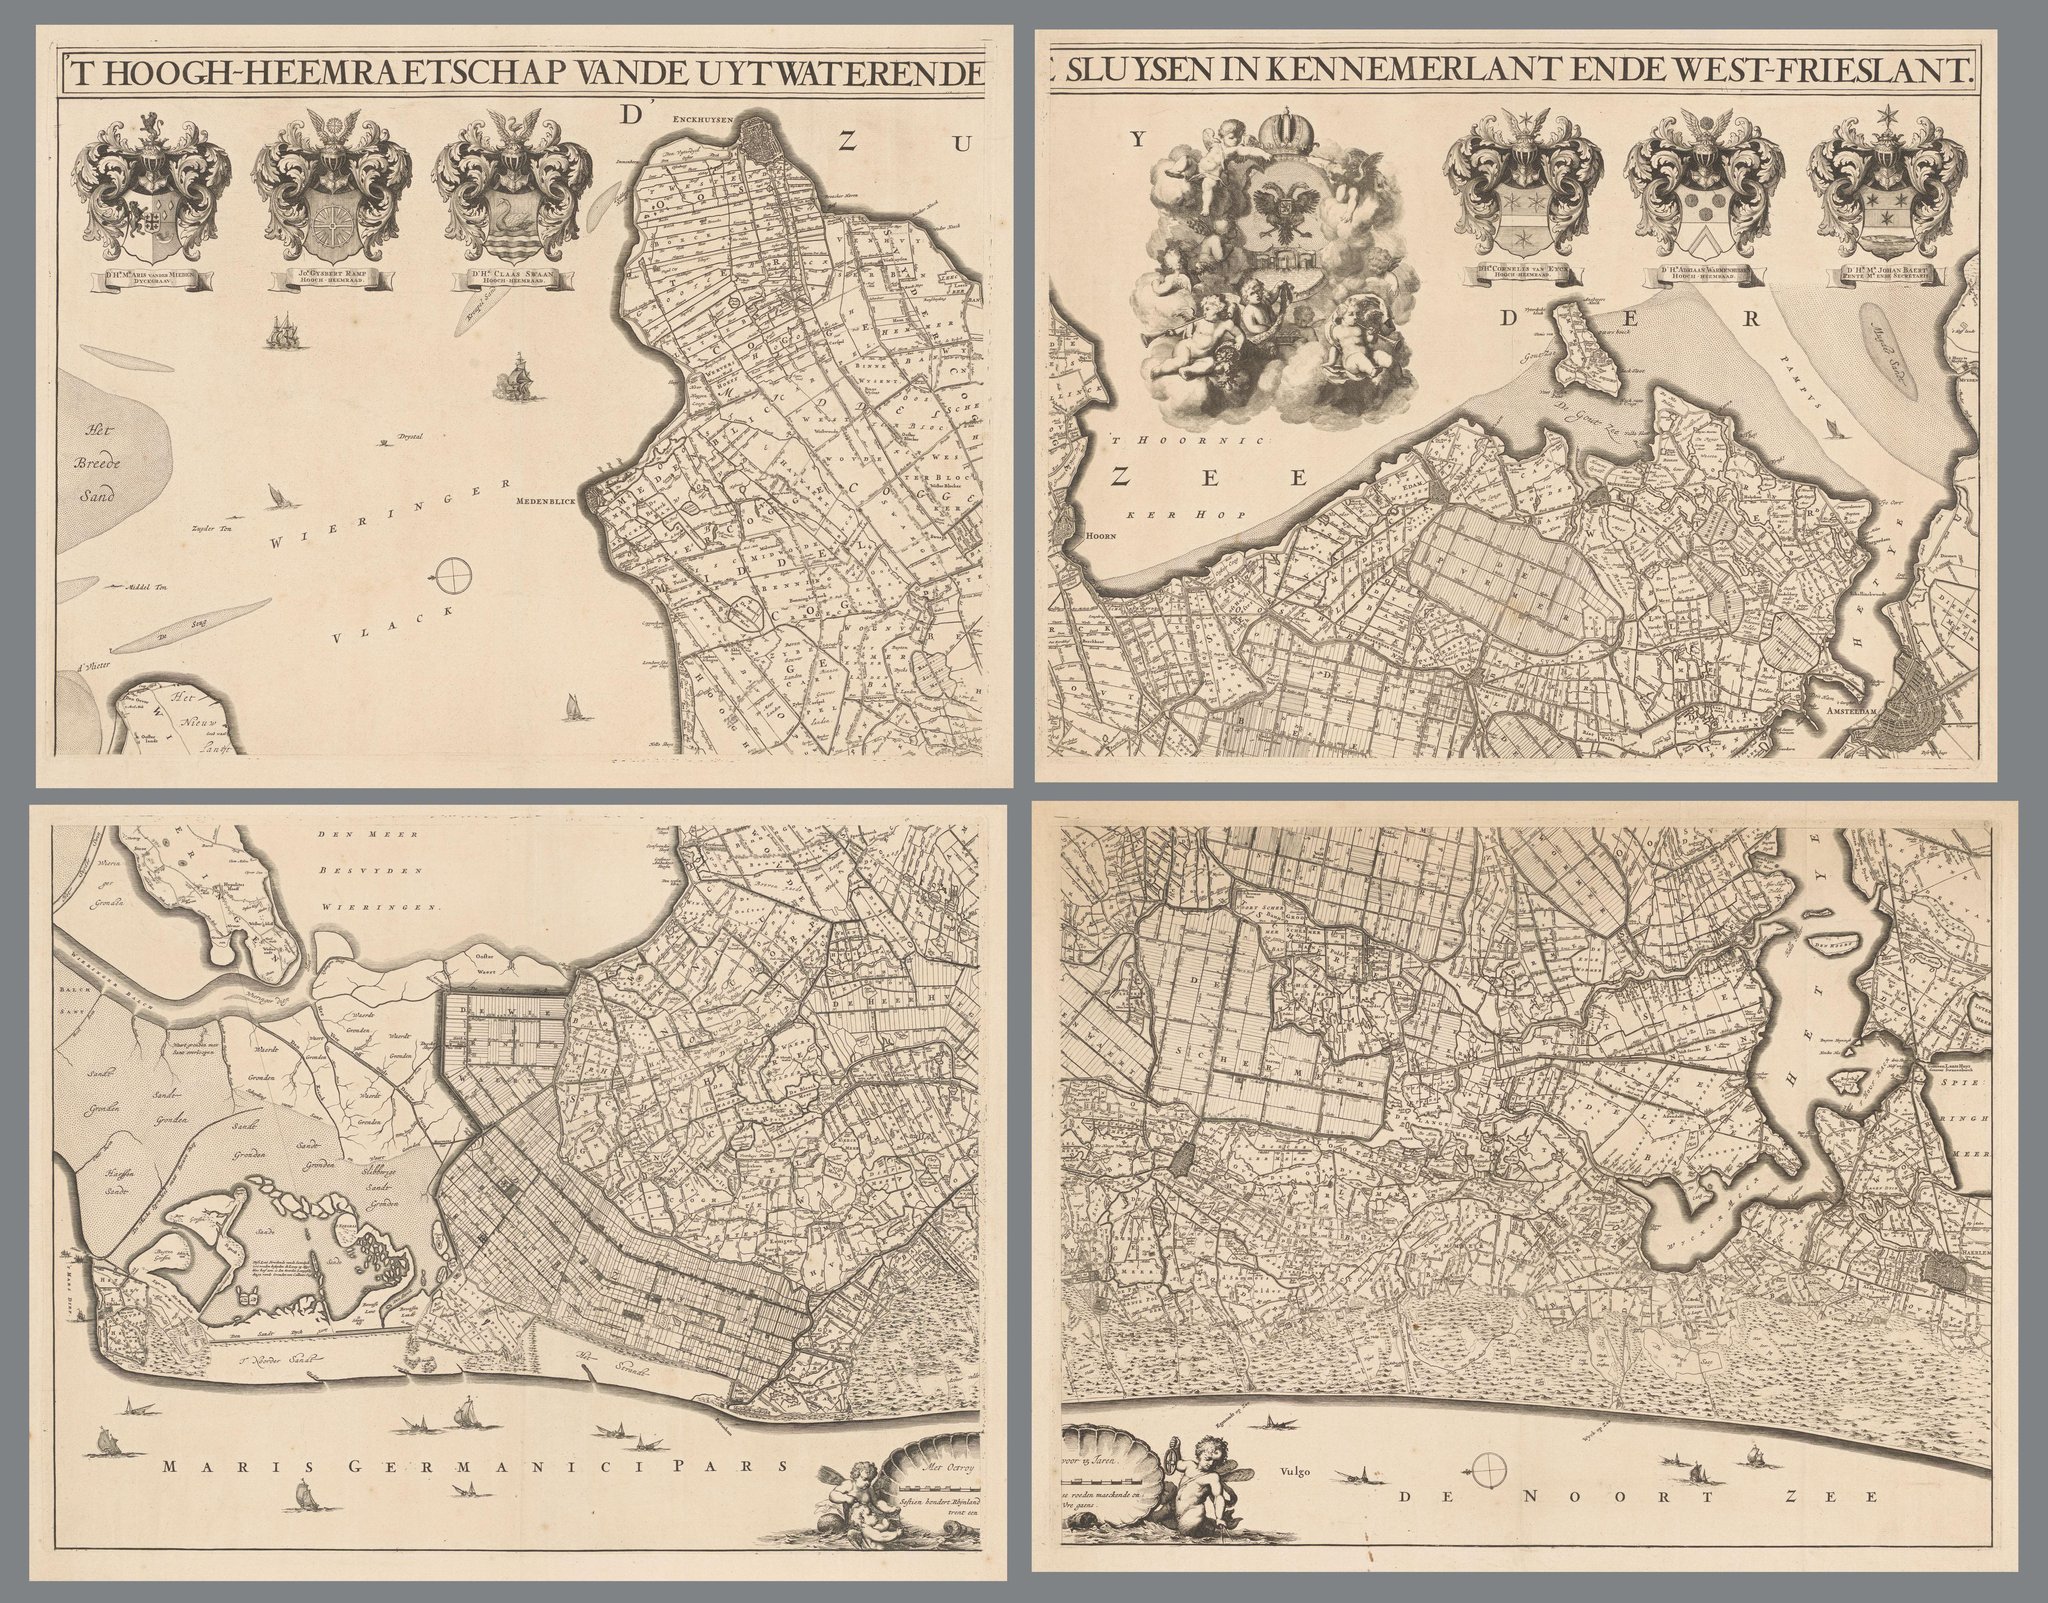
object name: print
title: 't Hoogh-heemraetschap vande Uytwaterende Sluysen in Kennemerlant ende West-Frieslant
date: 1734-1739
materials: paper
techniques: engraving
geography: amsterdam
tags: coat of arms (as symbol of the state, etc.), maps of separate countries or regions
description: Dit object is omwille van een betere presentatie virtueel samengevoegd maar bestaat fysiek uit losse onderdelen. In 1680 verscheen een zestiendelige wandkaart (RP-P-AO-6-26), vervaardigd door landmeter Jan Jansz. Dou in opdracht van het Hoogheemraadschap van de Uitwaterende Sluizen in Kennemerland en West-Friesland. Vlak daarna werd besloten tevens een vierblads (de huidige kaart, zie ook RP-P-AO-6-25A, RP-P-AO-6-25B en RP-P-AO-6-25D) en een éénblads uitgave (RP-P-AO-6-24-1 en RP-P-AO-6-24-2) te laten maken. Alle drie de kaarten werden gegraveerd door Coenraet Decker en Abraham Jansz. Deur, die verantwoordelijk was voor het graveren van de letters. Van deze drie kaarten bestaan verschillende staten, waarop telkens de namen en/of wapens van de dijkgraaf, hoogheemraden en rentmeester werden aangepast. De verschillende staten zijn gedateerd aan de hand van het archief van het hoogheemraadschap en/of de samenstelling van het bestuur (dijkgraaf, hoogheemraden en rentmeester).